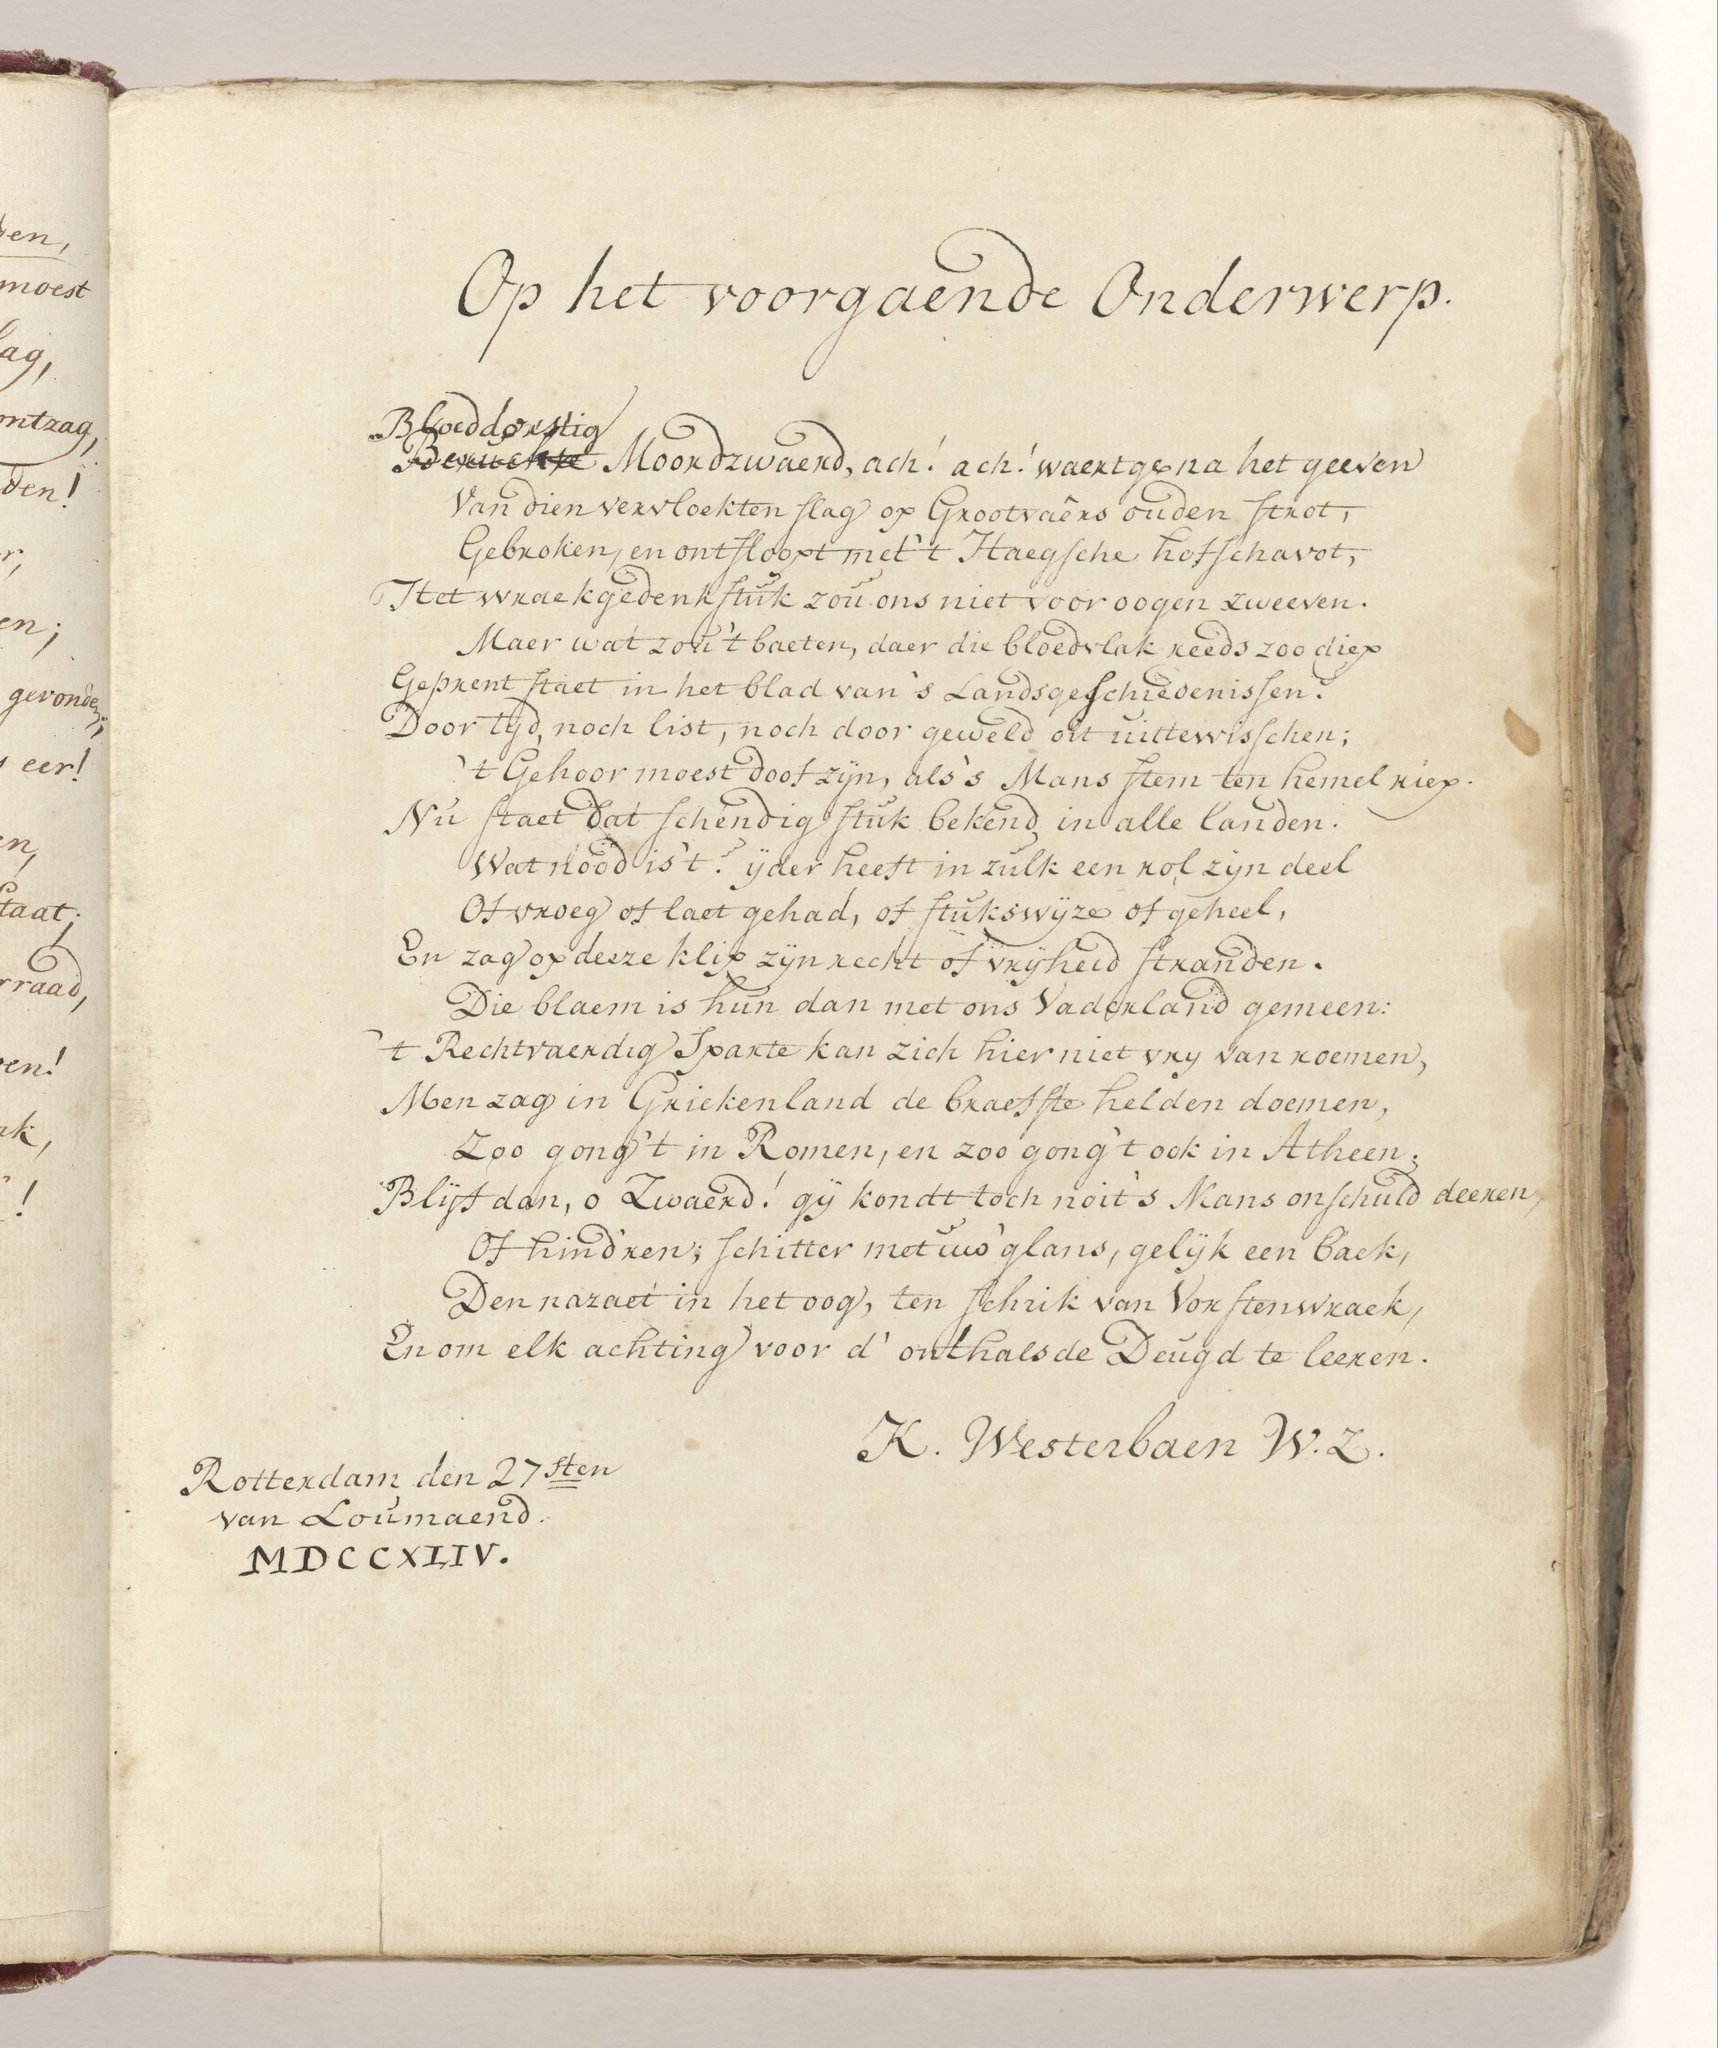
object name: manuscript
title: Op het voorgaende Onderwerp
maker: kornelis westerbaen willemsz.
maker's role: schrijver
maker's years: 1690-1774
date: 1744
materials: ink, paper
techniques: writing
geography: netherlands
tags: johan van oldenbarnevelt, dordrecht, print maker, frans greenwood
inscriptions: date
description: Vers van Kornelis Westerbaen Wz. Onderdeel van het boek met gedichten uit de jaren 1743-1745 op het zwaard waarmee Johan van Oldenbarnevelt in 1619 zou zijn onthoofd. Het zwaard was eigendom van Frans Greenwood.